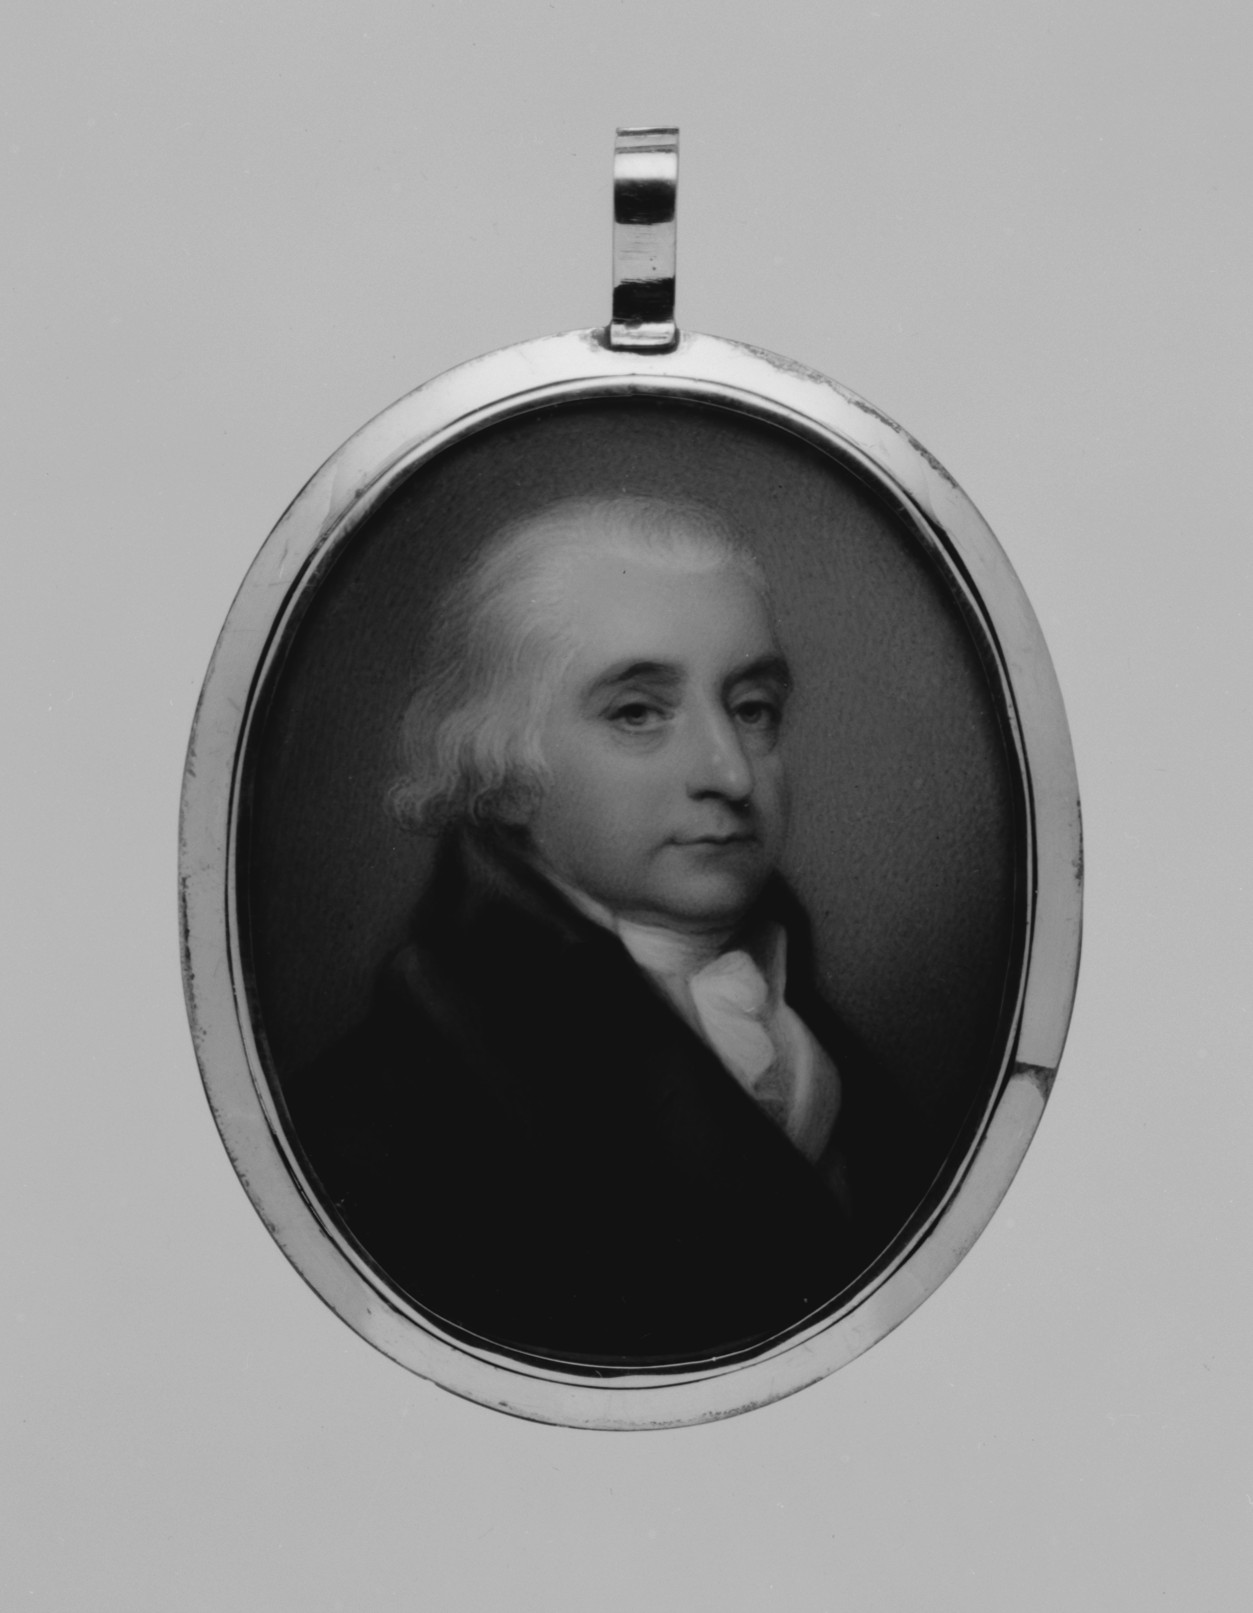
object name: painting, miniature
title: Henry Hope (1735/36–1811), after Jones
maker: henry bone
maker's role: artist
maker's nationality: british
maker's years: 1755-1834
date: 1802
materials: enamel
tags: men,portraits